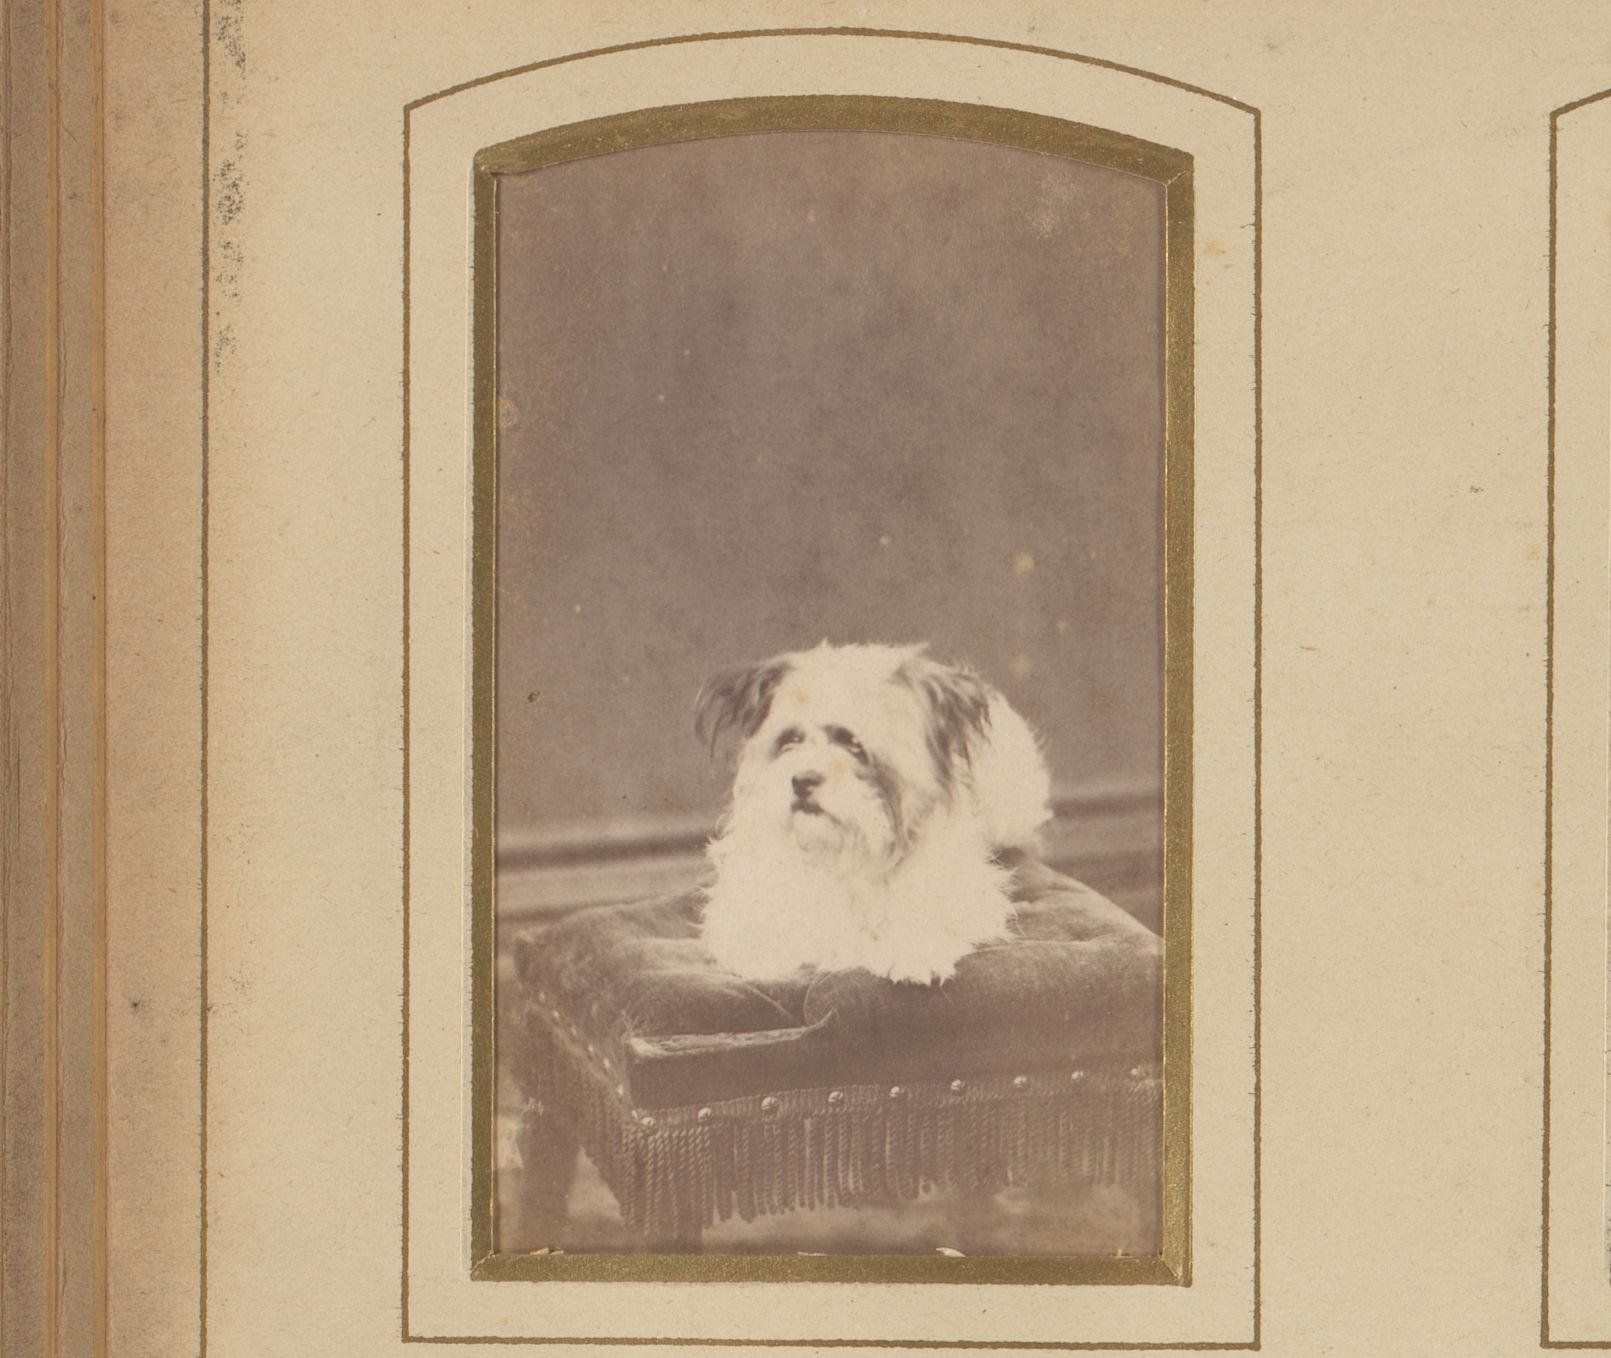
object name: album leaf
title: Portret van een hond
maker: thomas holt challis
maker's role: fotograaf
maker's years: 1846-1927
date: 1860-1900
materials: cardboard, photographic support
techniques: albumen print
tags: dog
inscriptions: inscription: ‘T.H. Challis/ St Johns Studio/ Sevenoaks/ (...)’